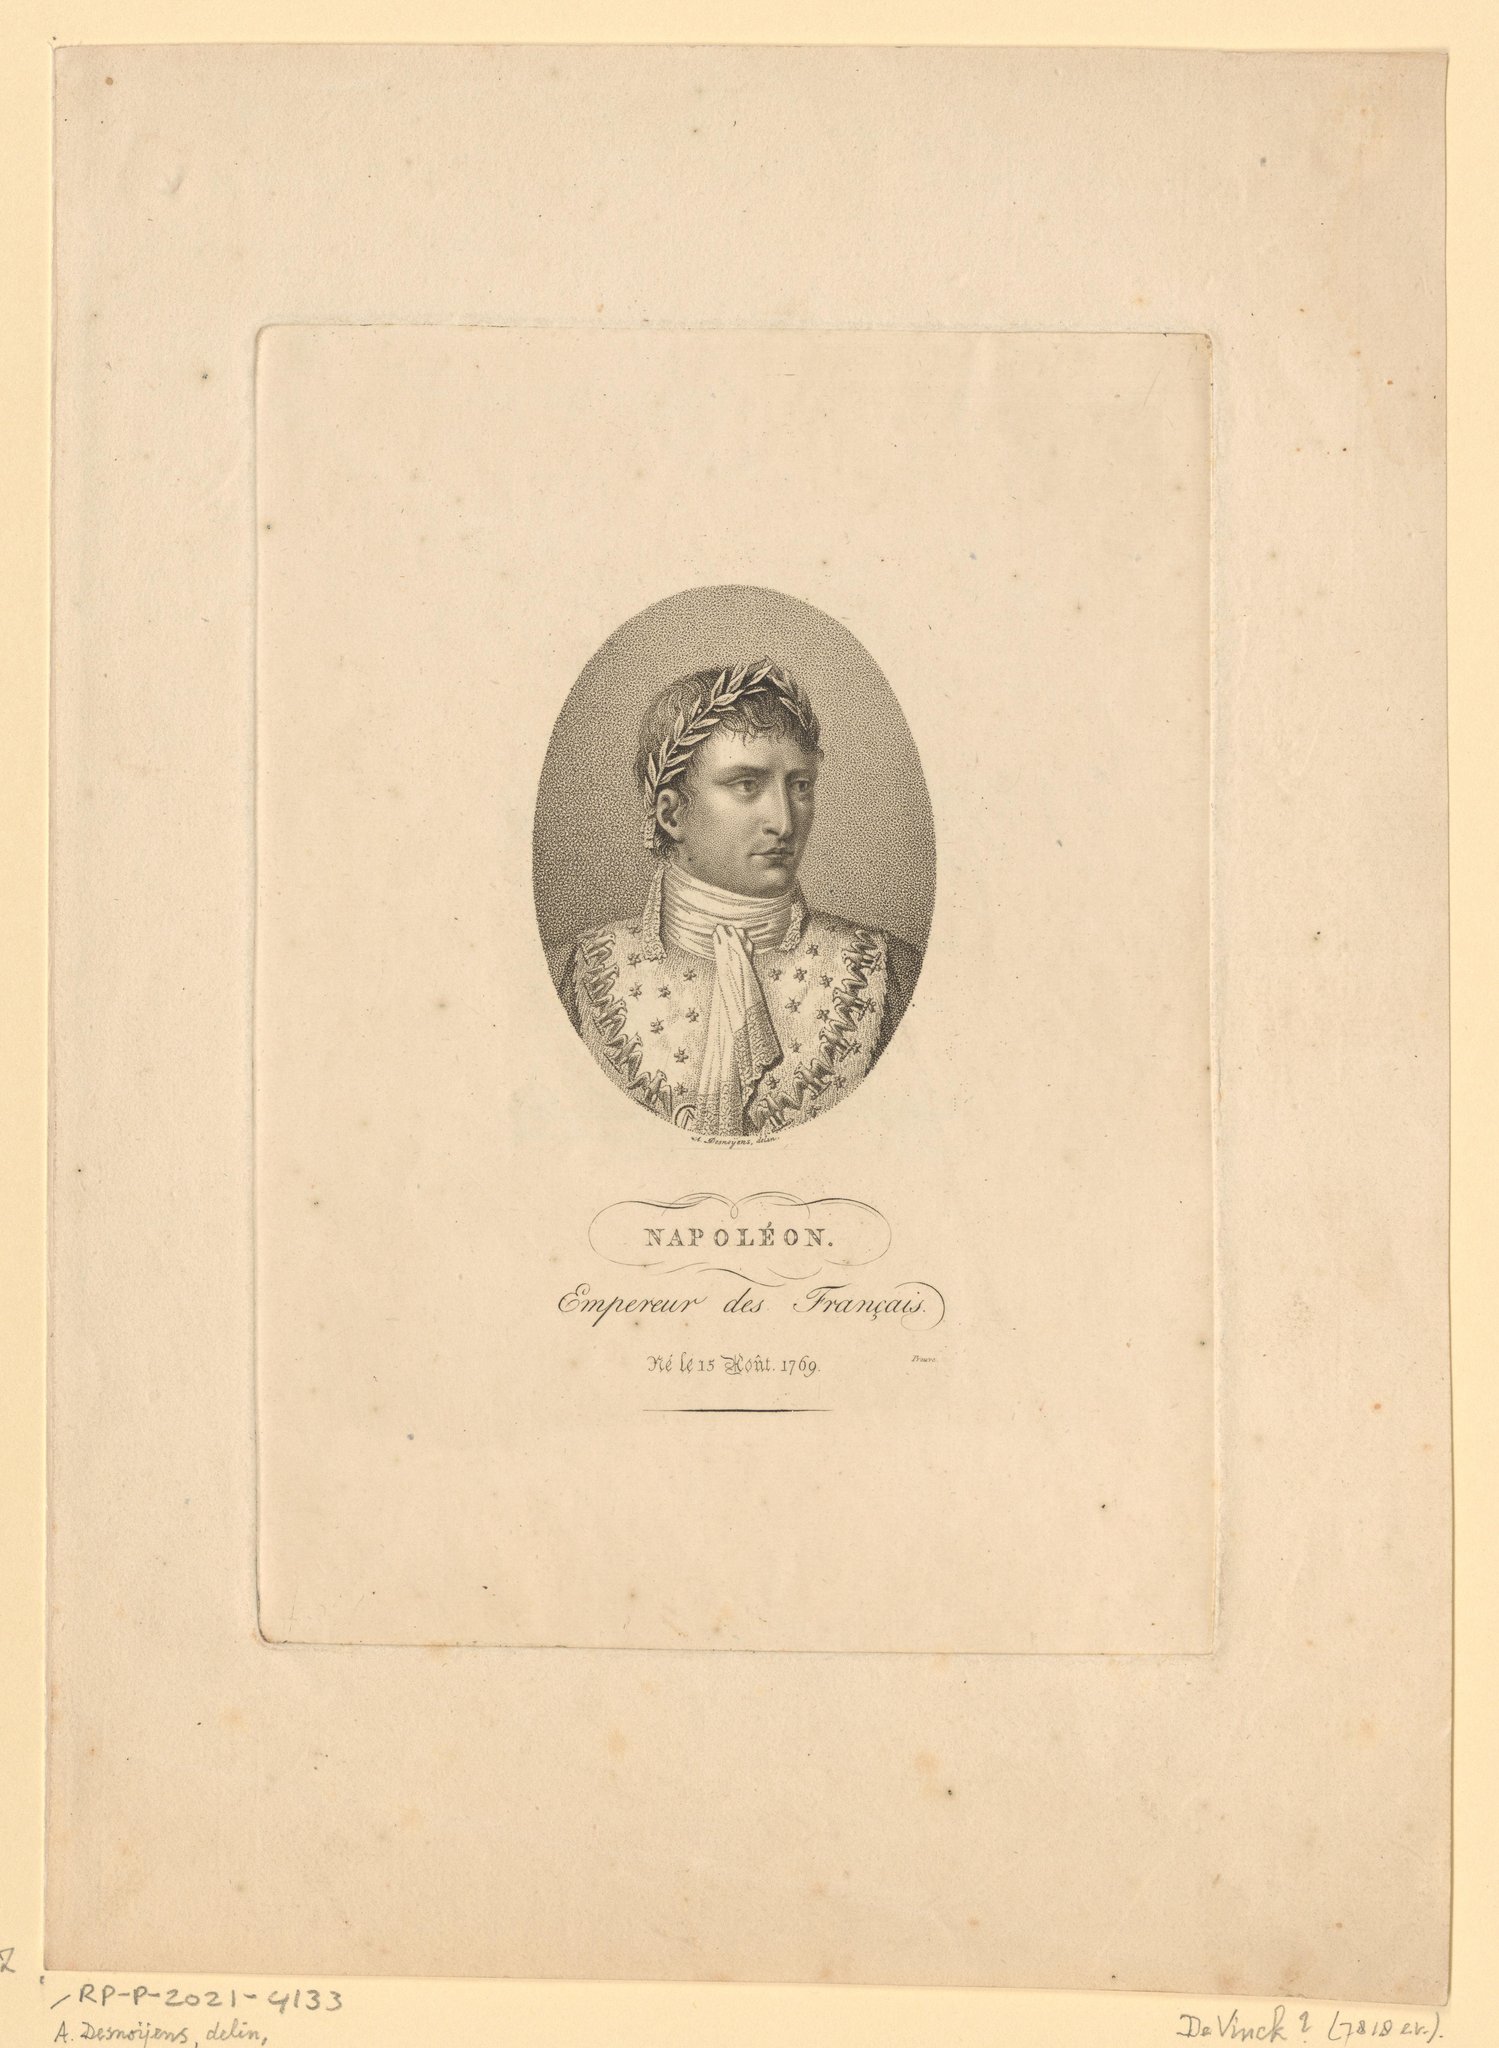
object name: print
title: Portret van Napoleon I Bonaparte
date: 1804-1821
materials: paper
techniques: engraving, letterpress printing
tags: napoleon i (emperor of the french), historical persons, emperor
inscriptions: inscription: ‘No. 526’